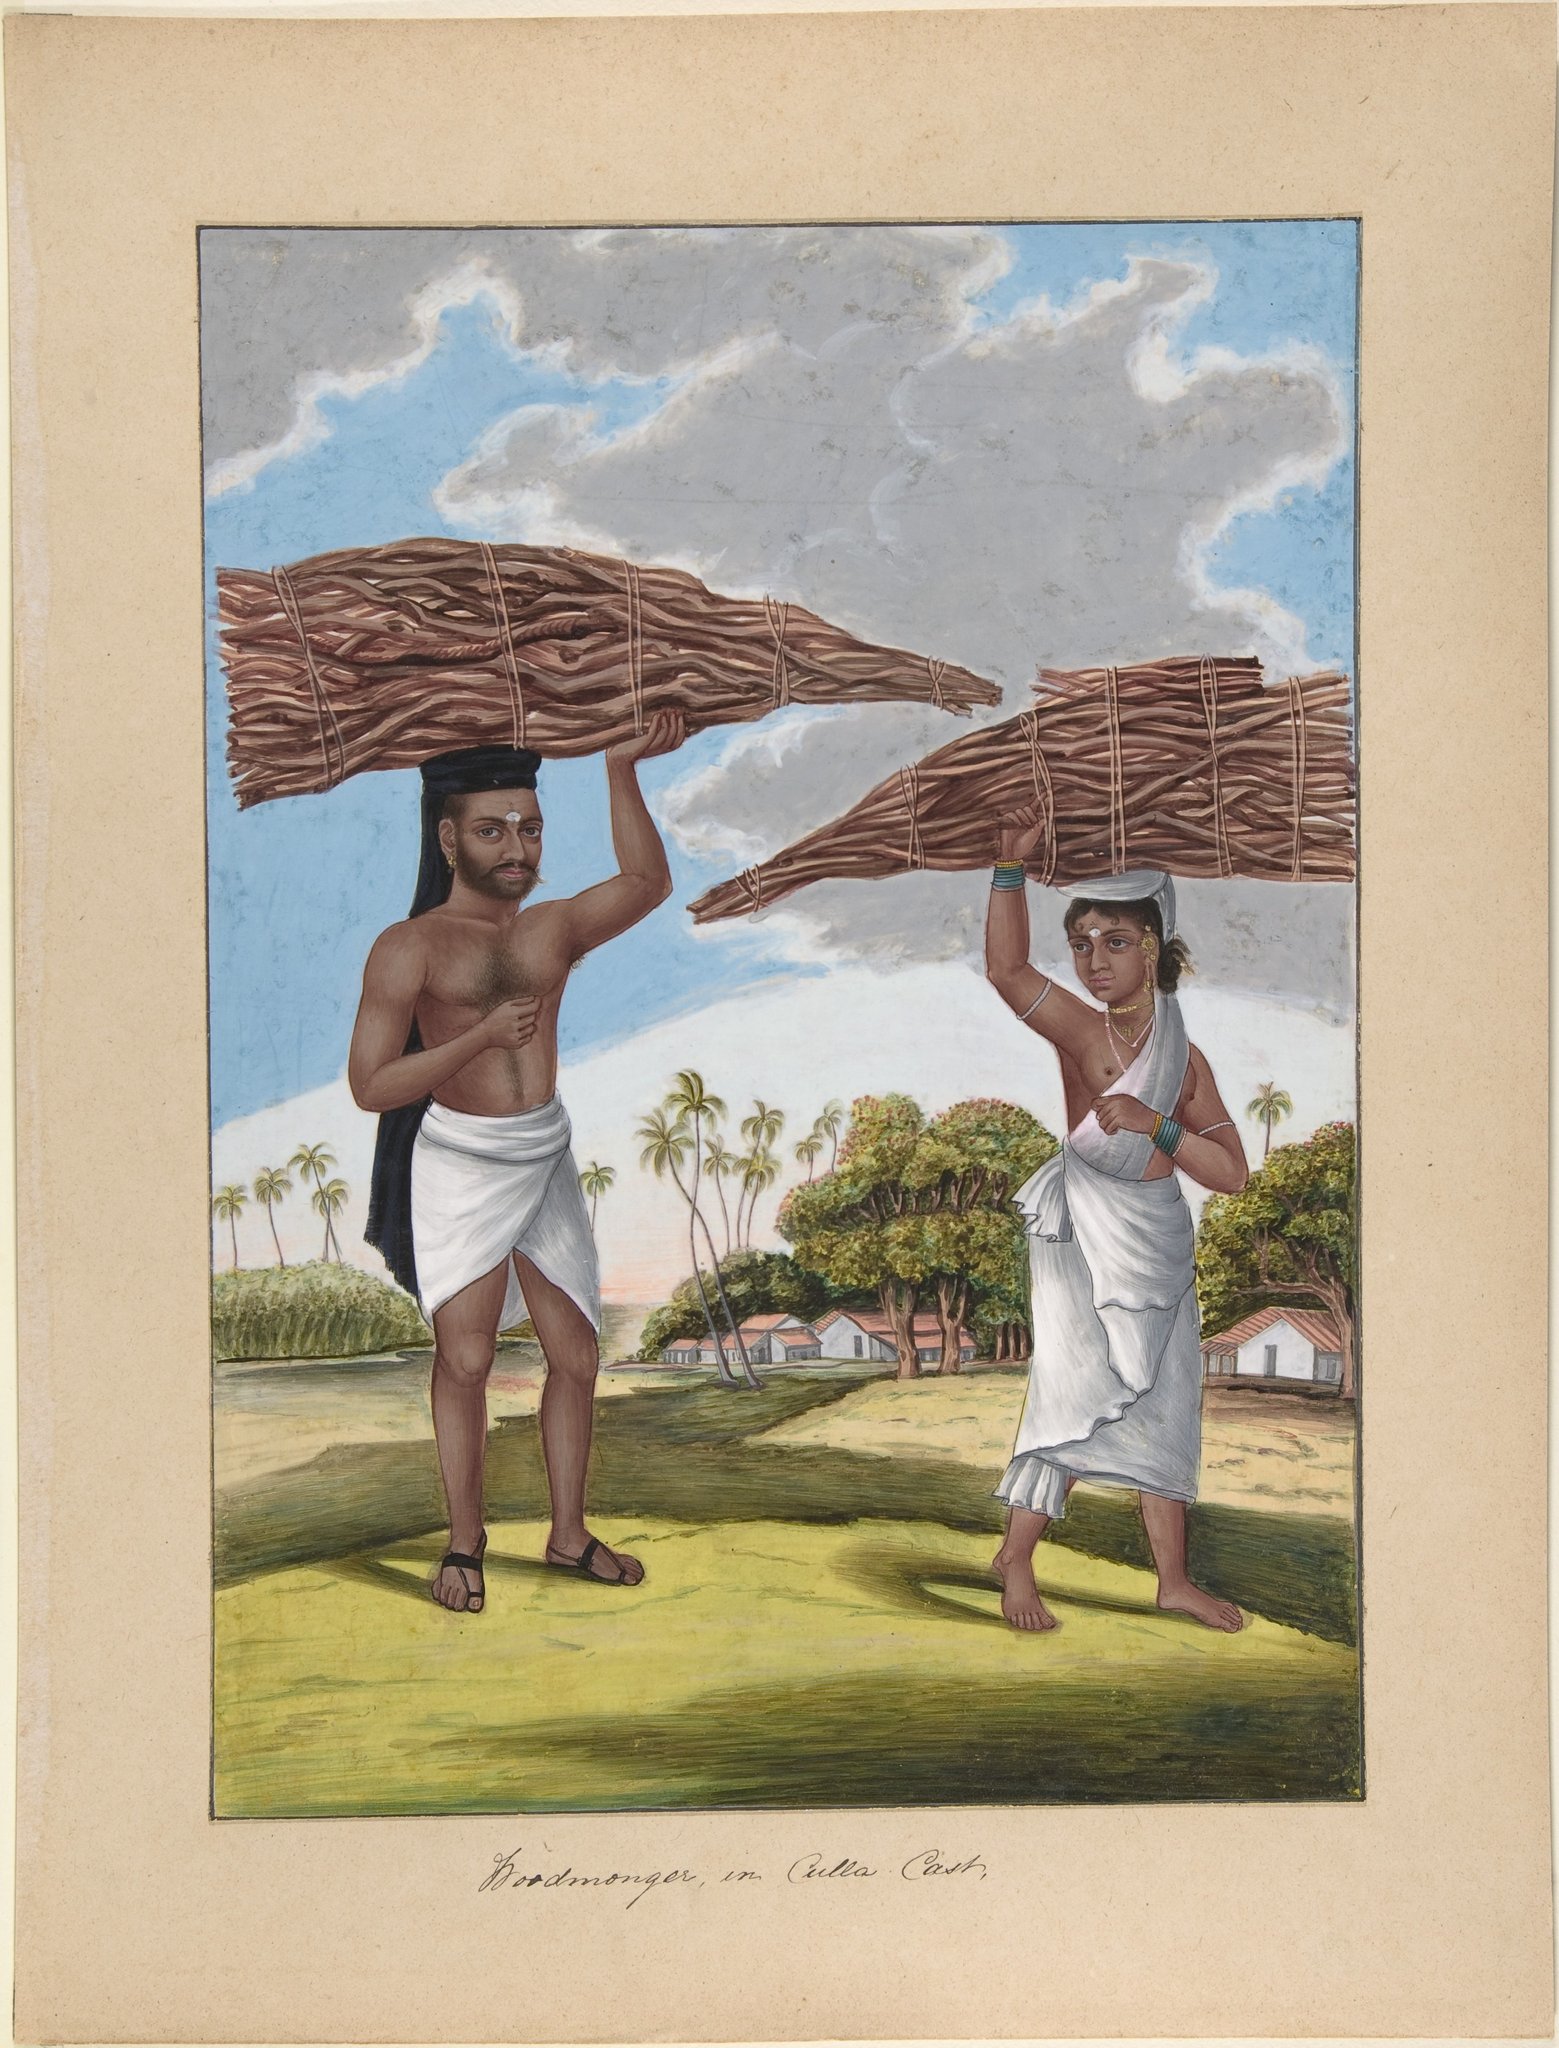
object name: drawing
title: Woodmonger in Culla Caste, from Indian Trades and Castes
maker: anonymous, indian, 19th century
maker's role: artist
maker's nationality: indian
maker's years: 1800-1900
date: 1840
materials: gouache, watercolor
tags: men,women